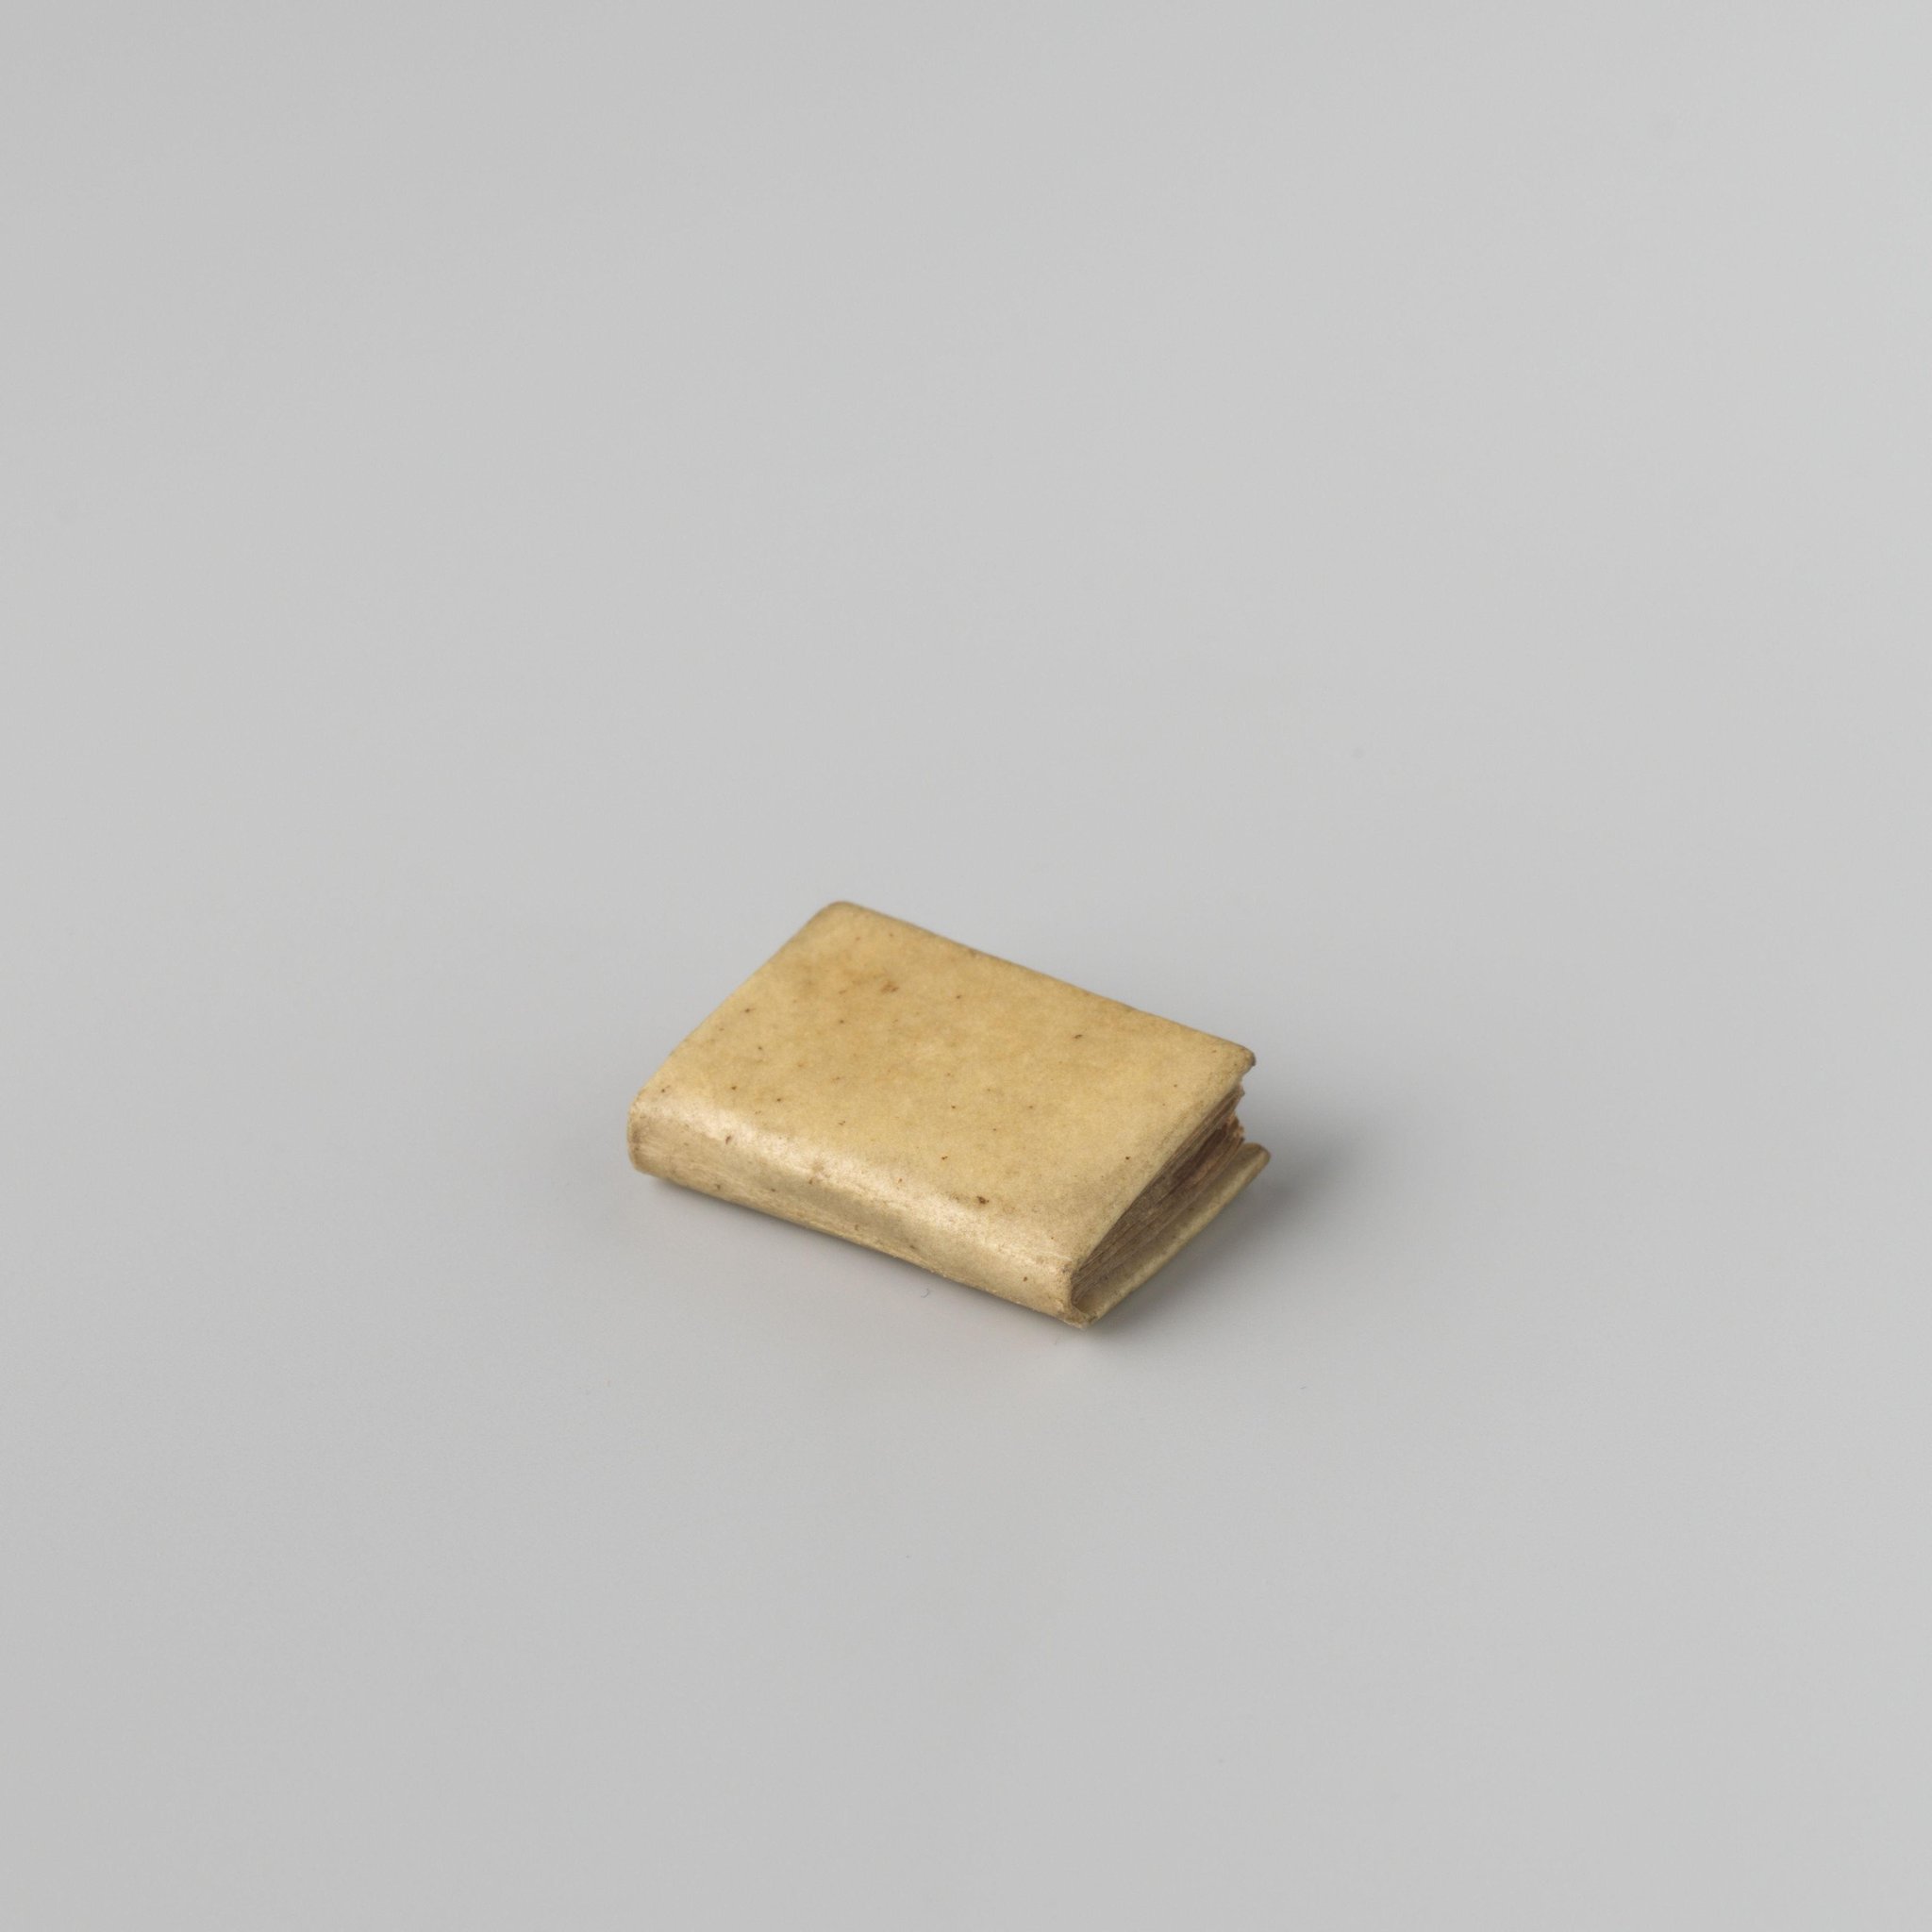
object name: book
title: Boek met figuren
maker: Anonymous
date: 1690-1710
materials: paper, parchment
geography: amsterdam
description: Boek met figuren. Ingebonden in blank perkament.